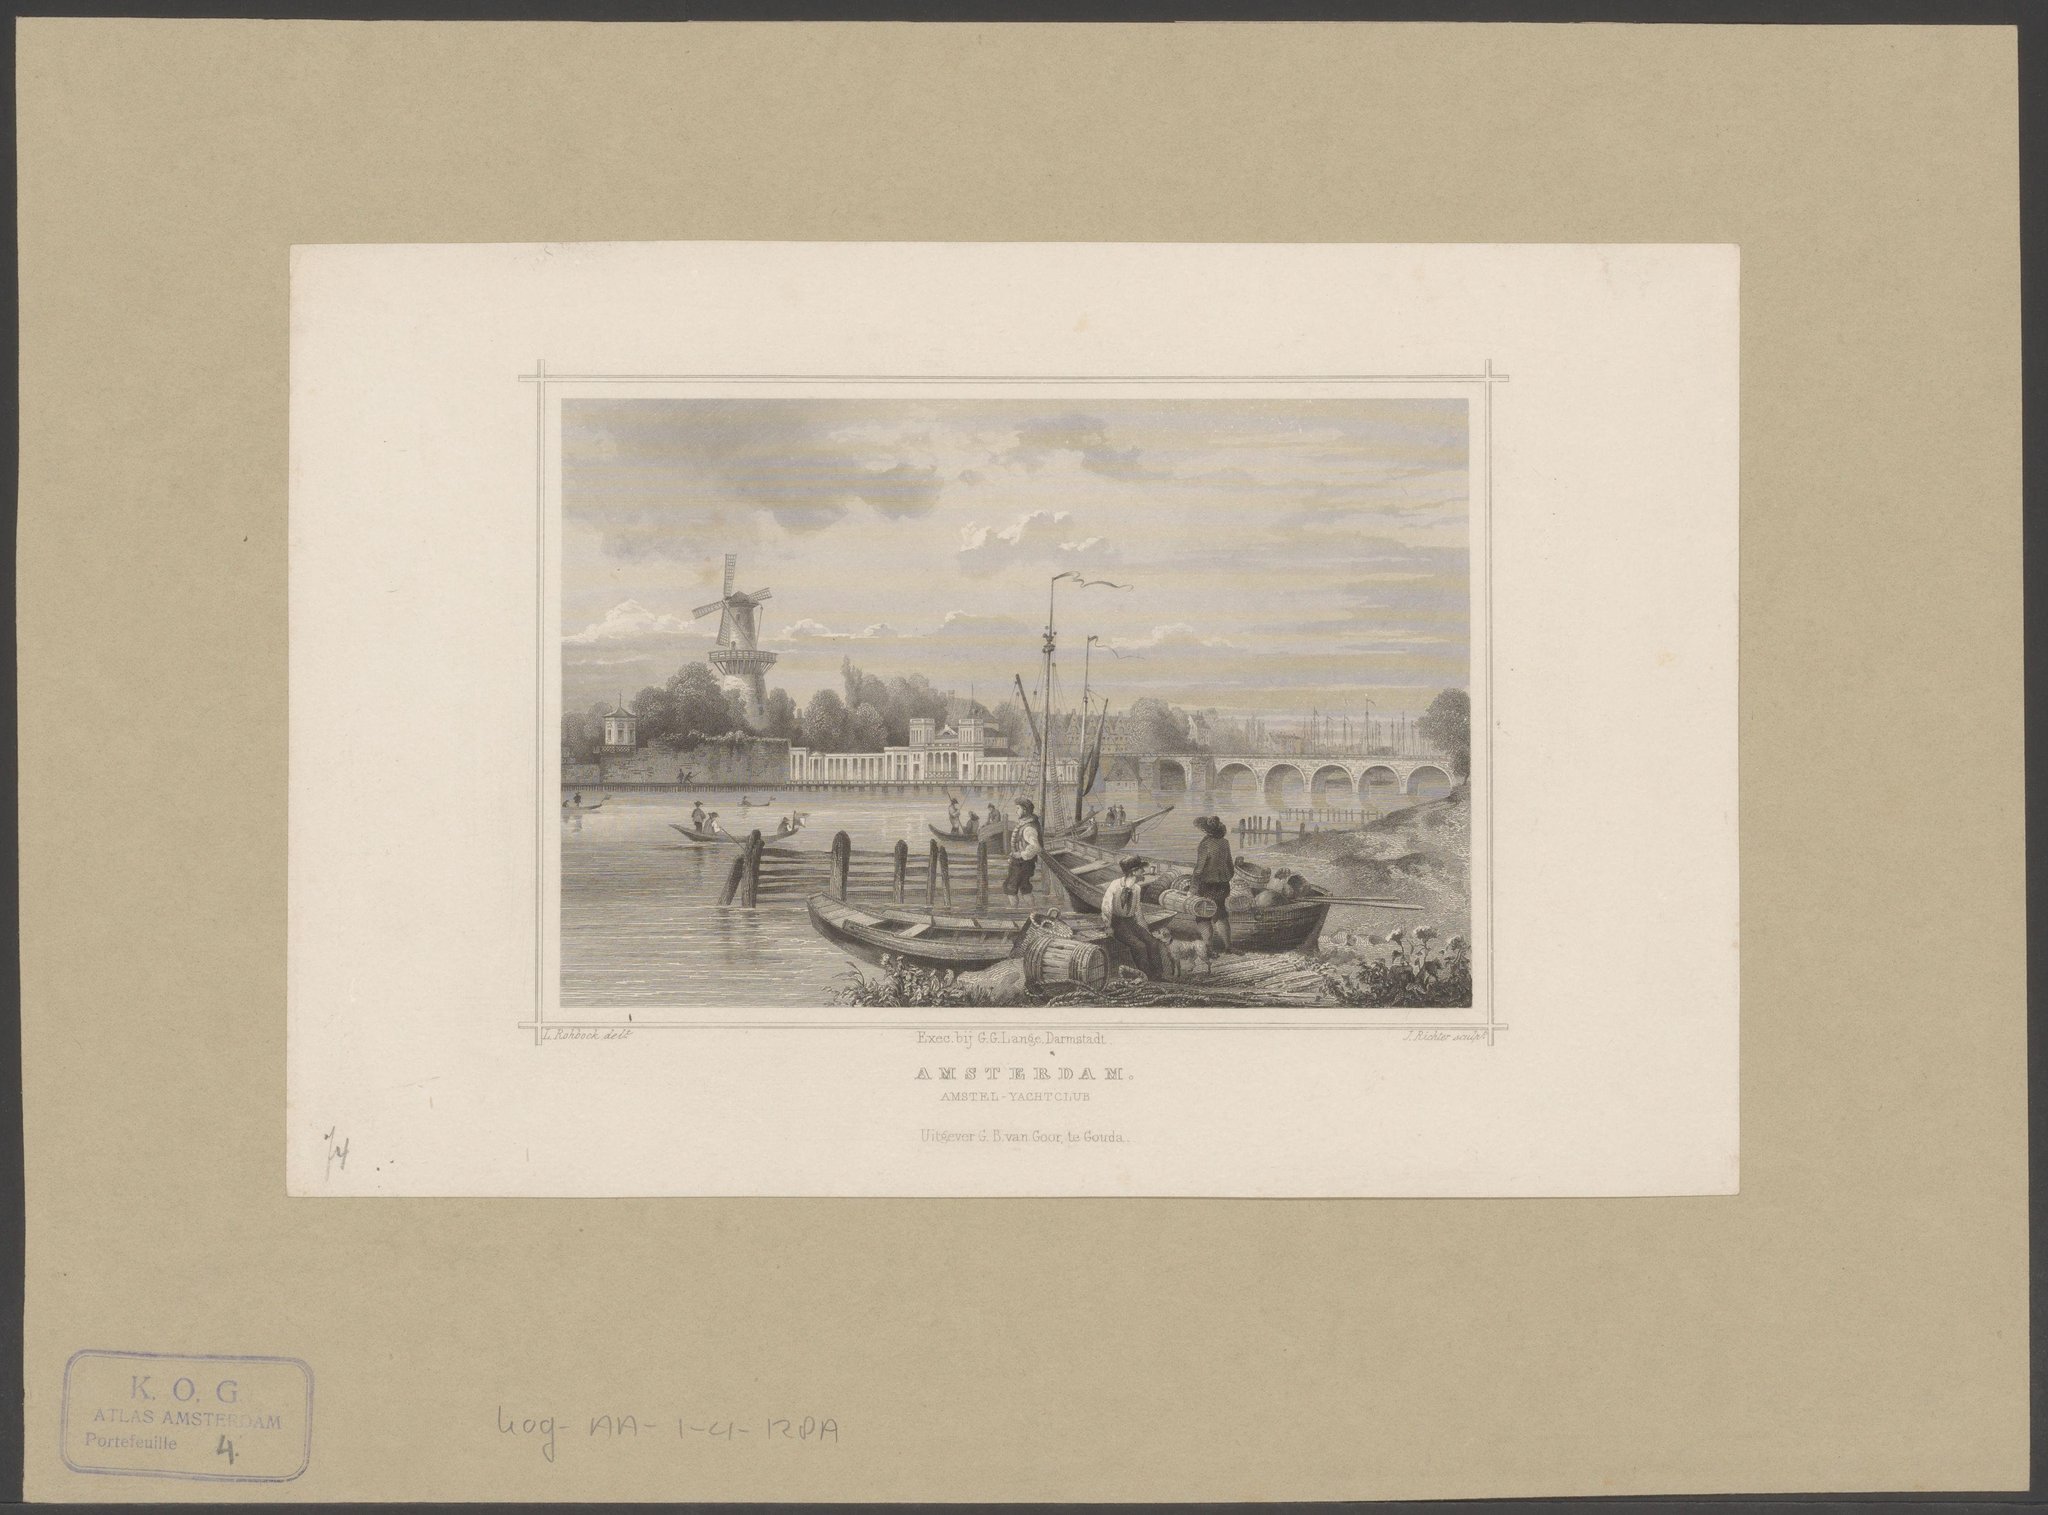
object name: print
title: Gezicht op de Amstel Jachthaven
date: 1857-1862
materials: paper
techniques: engraving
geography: darmstadt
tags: city-view in general; 'veduta', river, windmill in landscape, bridge in city across river, canal, etc., boat propelled by man or animal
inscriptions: collector's mark: ‘4’ Lugt 1641b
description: Prent waarschijnlijk uit een deel van: Terwen, J.L. Het koningrijk der Nederlanden (...). 2 dln. Gouda: G.B. van Goor, 1857. Of uit: Der Rhein und die Rheinlande in malerischen Original-ansichten. 3 dln. Darmstadt: G.G. Lange, [1858-1862].